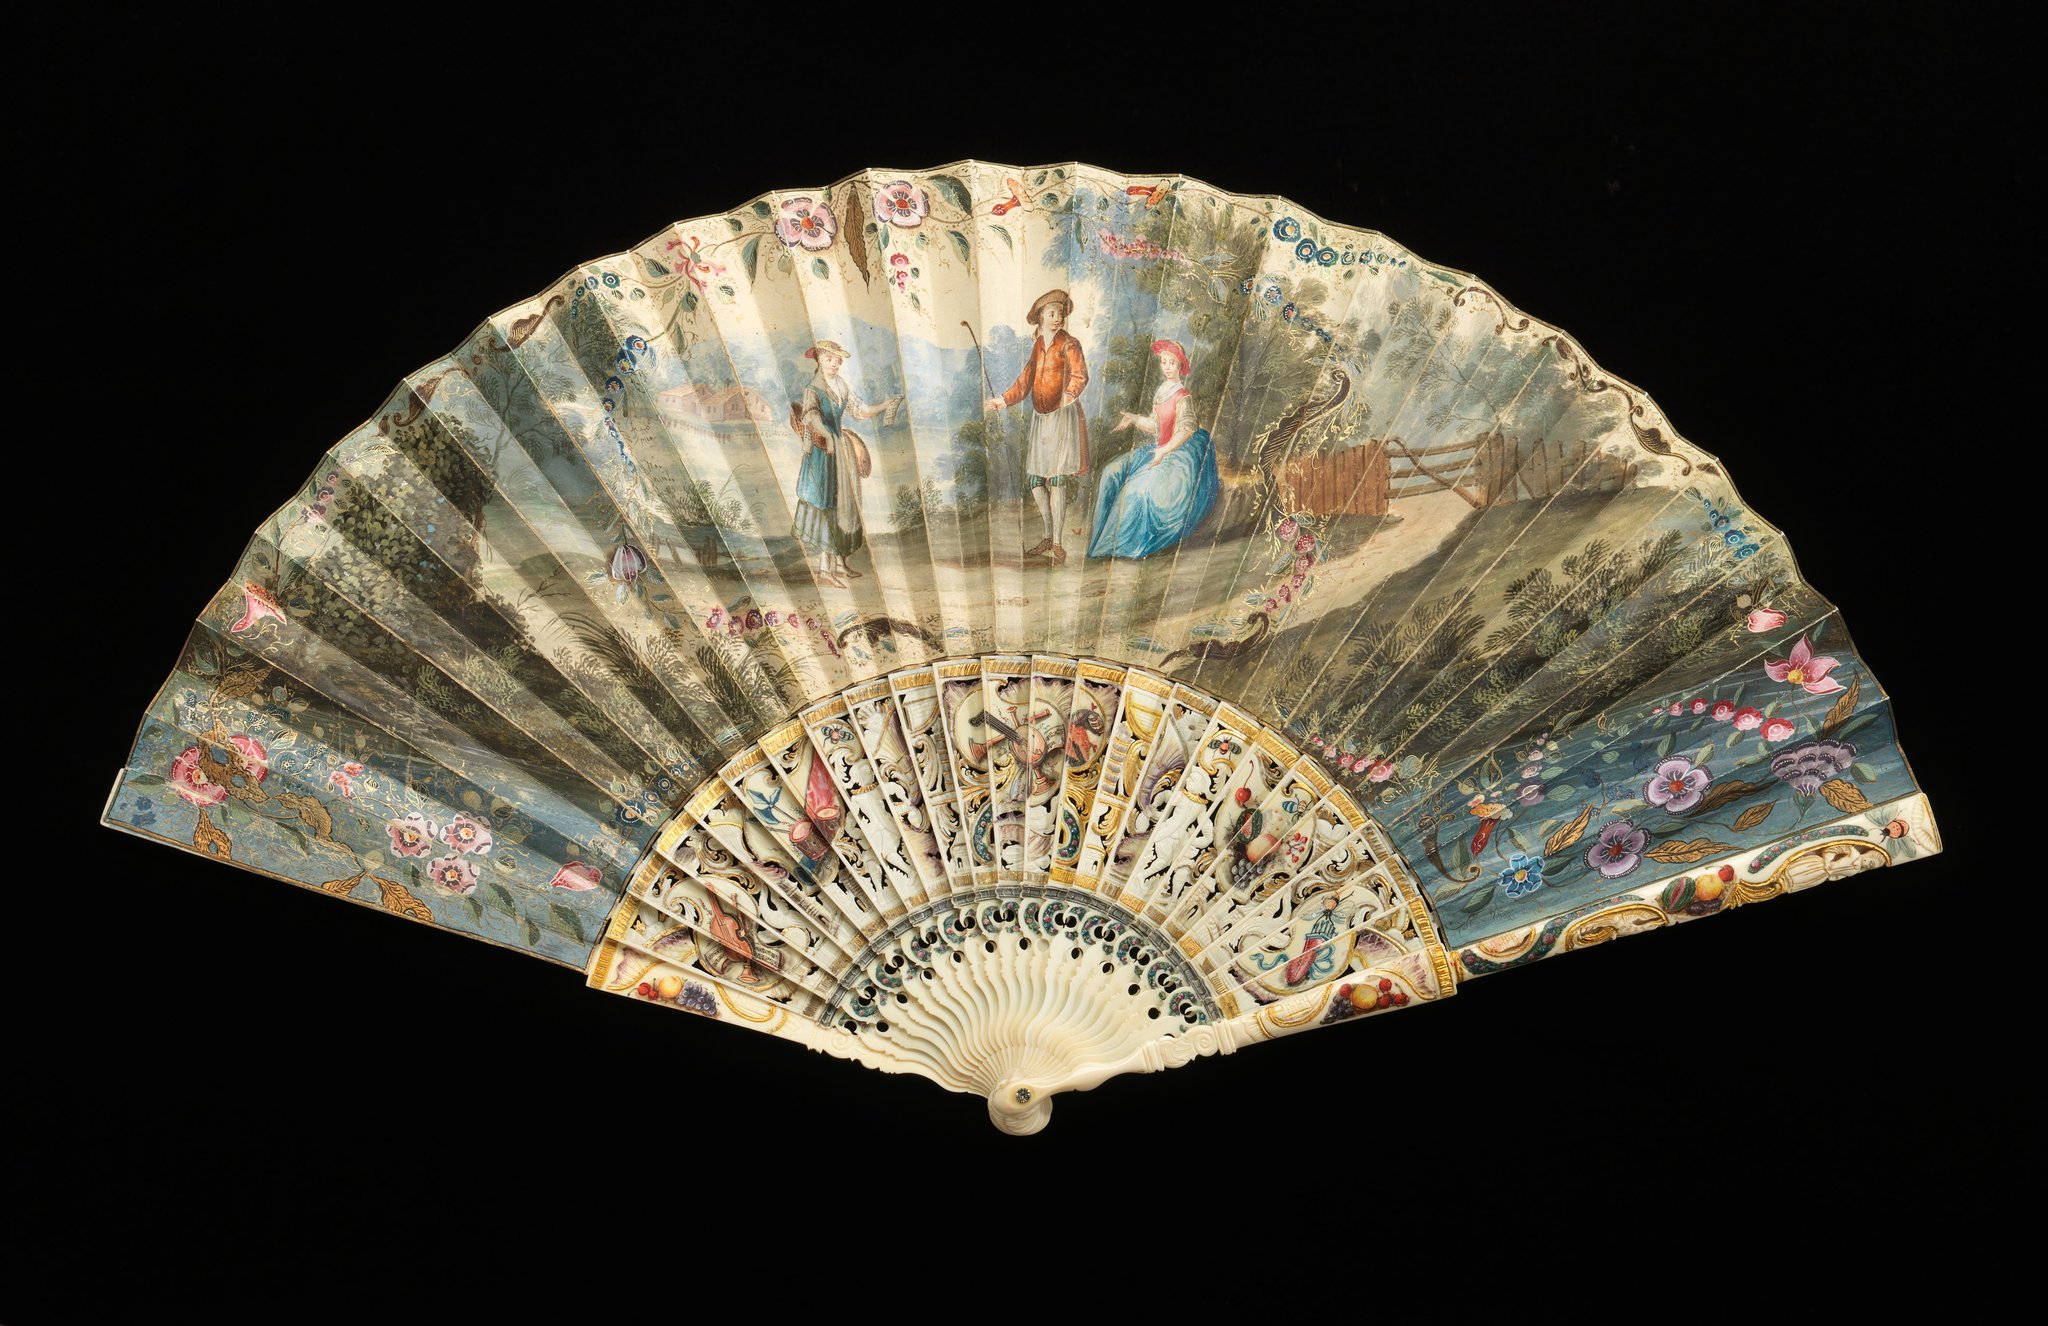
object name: fan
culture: french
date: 1715-1725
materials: gouache, ivory, paint, parchment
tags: men,women